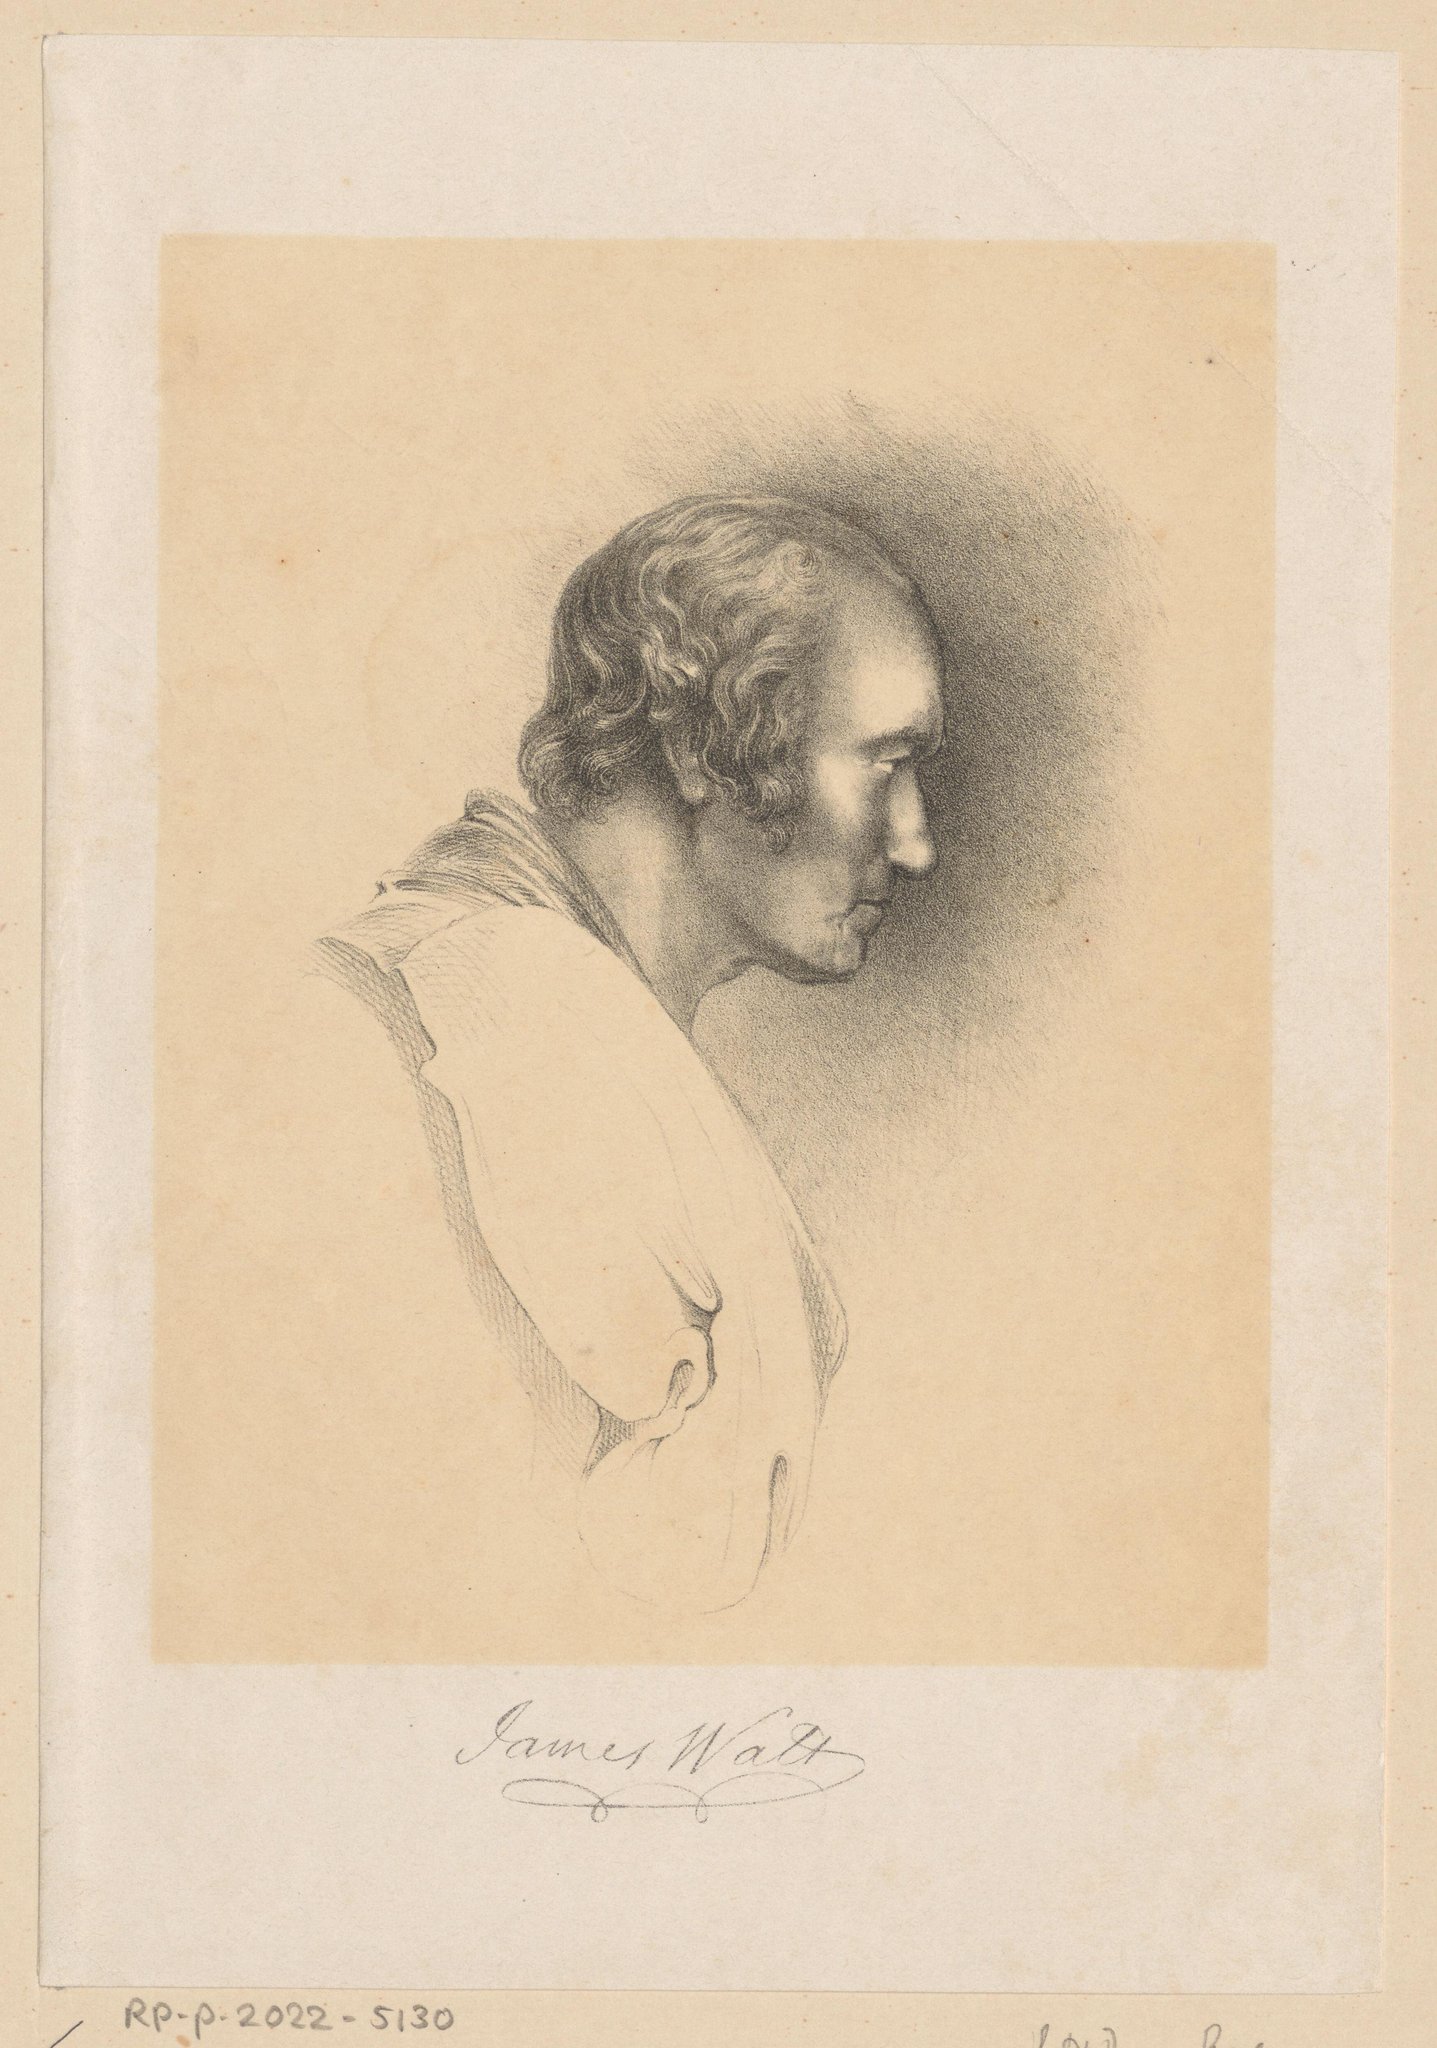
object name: print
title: Portret van James Watt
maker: Anonymous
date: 1800-1899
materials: paper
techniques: tone lithography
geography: england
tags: historical persons